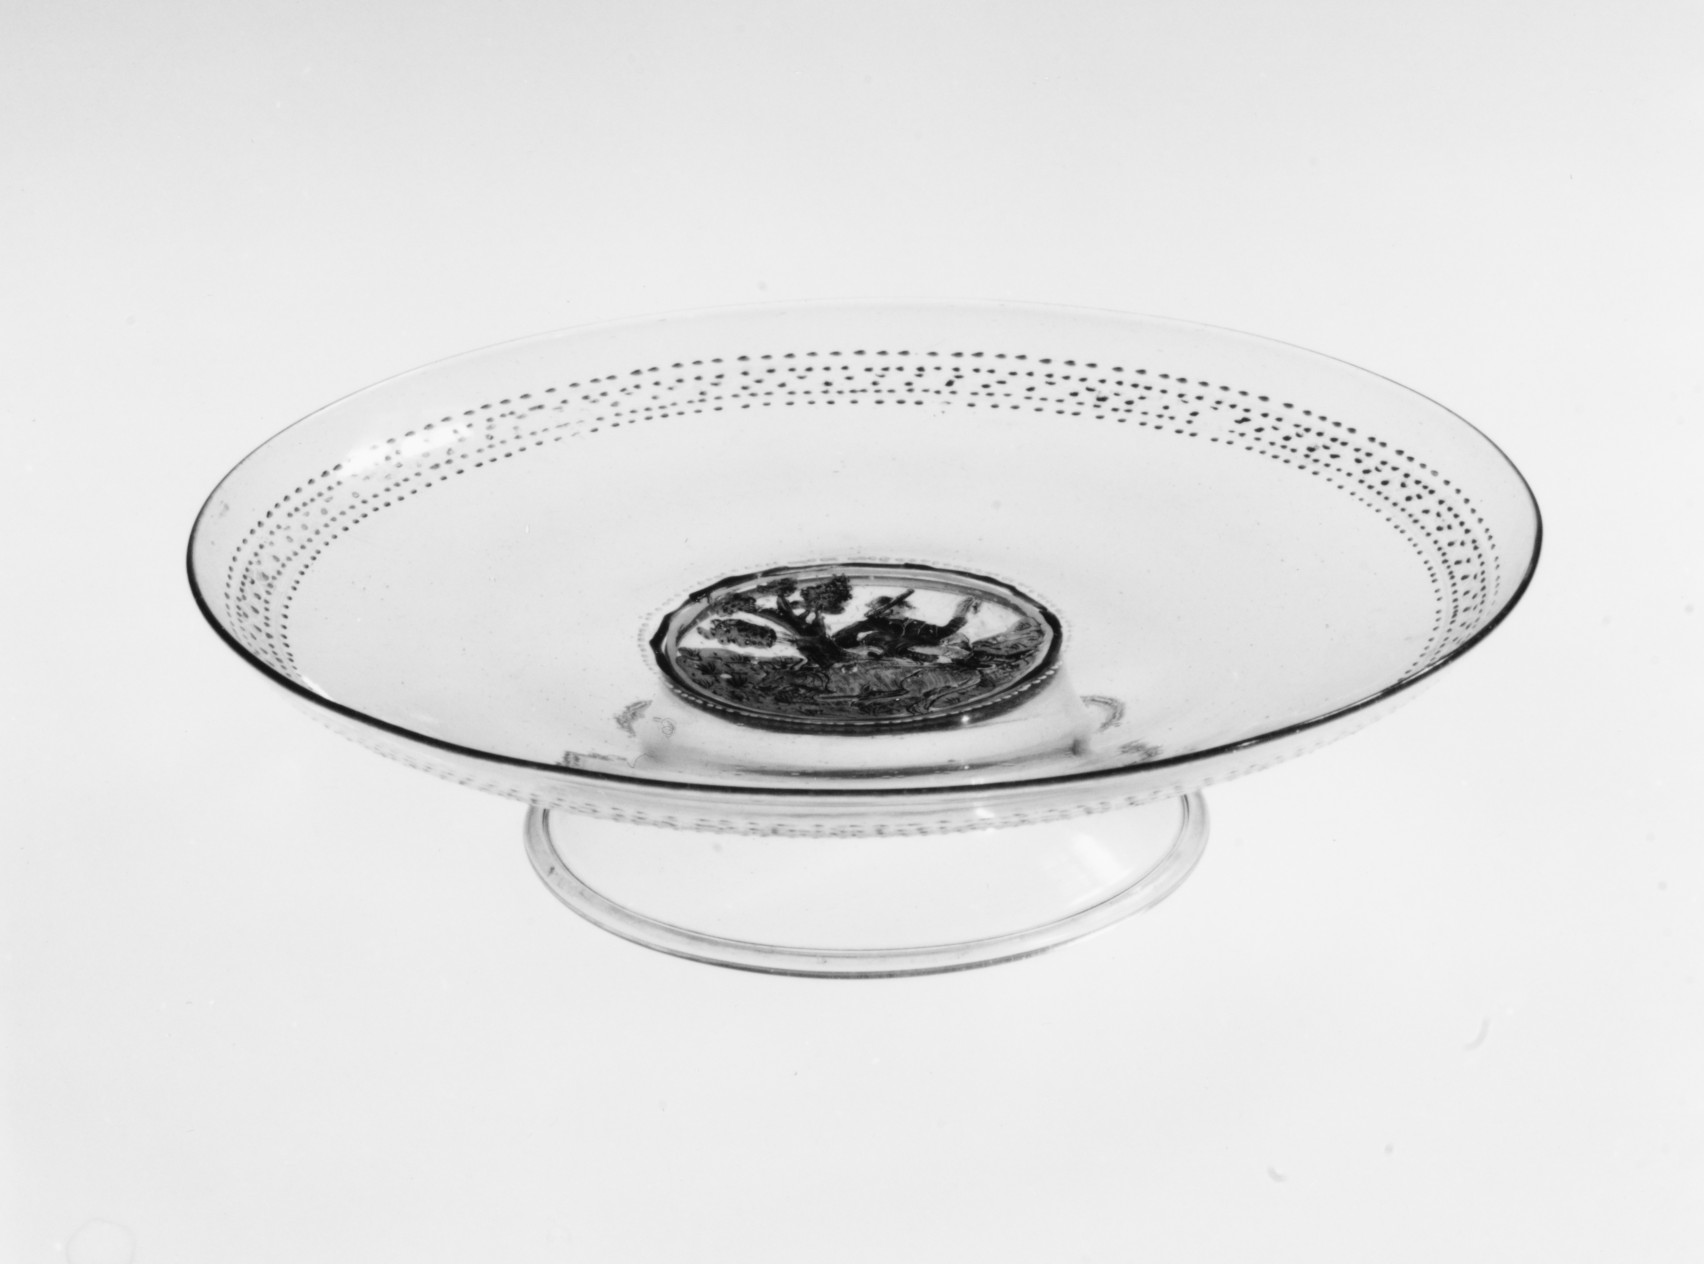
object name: tazza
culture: italian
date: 1500-1525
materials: gilt, glass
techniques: glassblowing, enamel